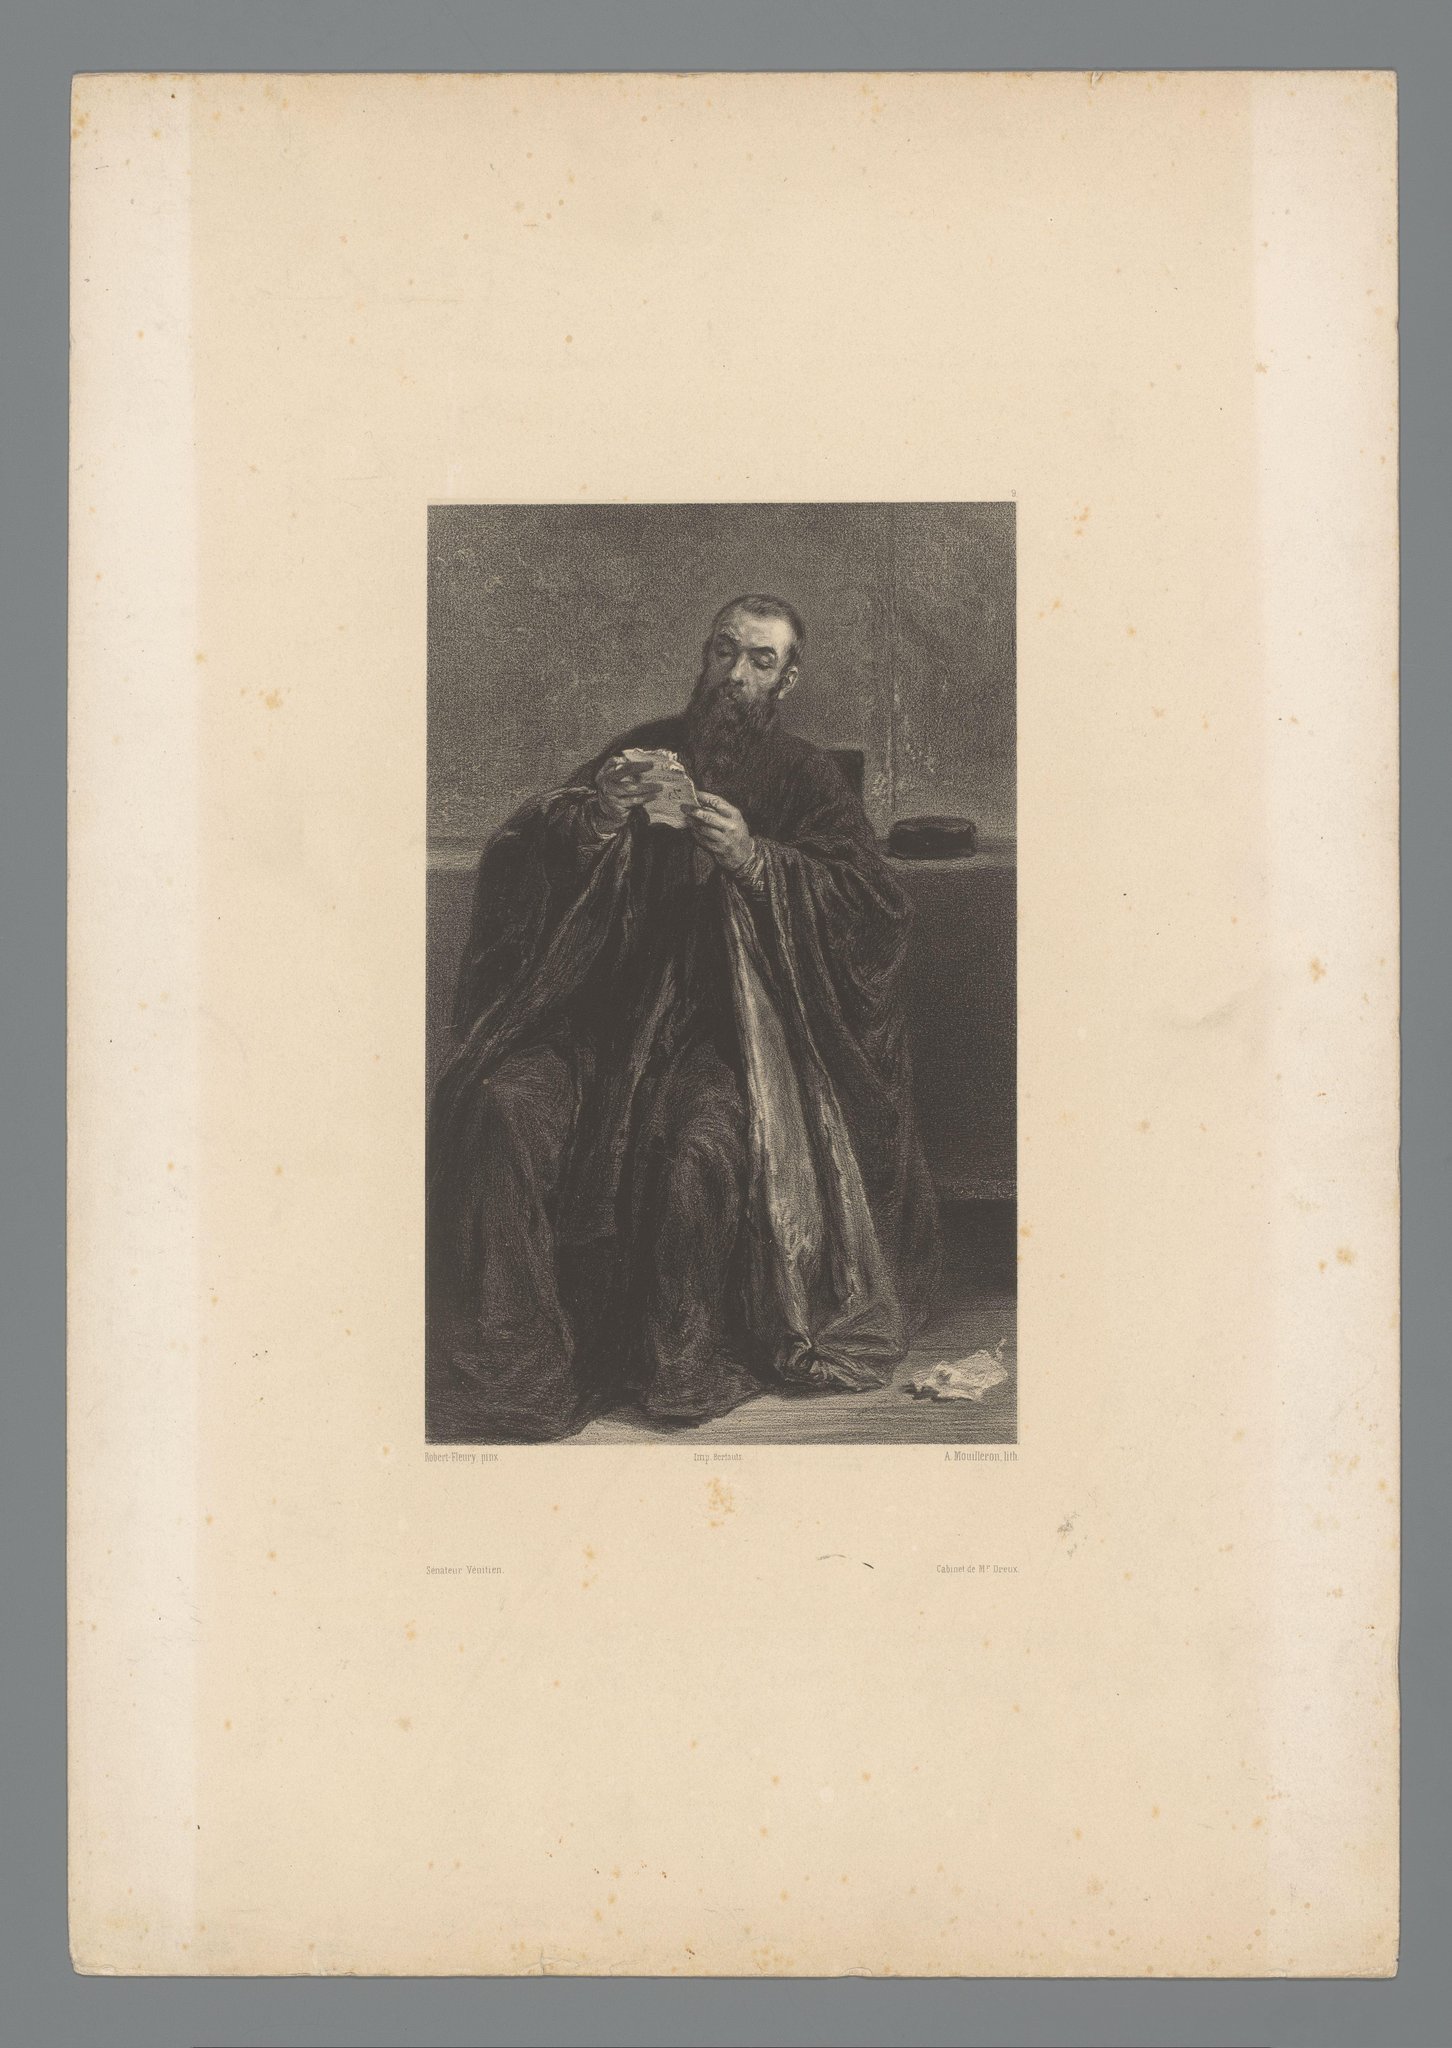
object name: print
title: Sénateur vénitien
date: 1848-1862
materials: paper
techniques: lithograph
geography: paris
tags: politician, e.g. party leader, venice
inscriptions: collector's mark: Lugt 2233, inscription: ‘Aug Allebé’, check stamp: Lugt 36a